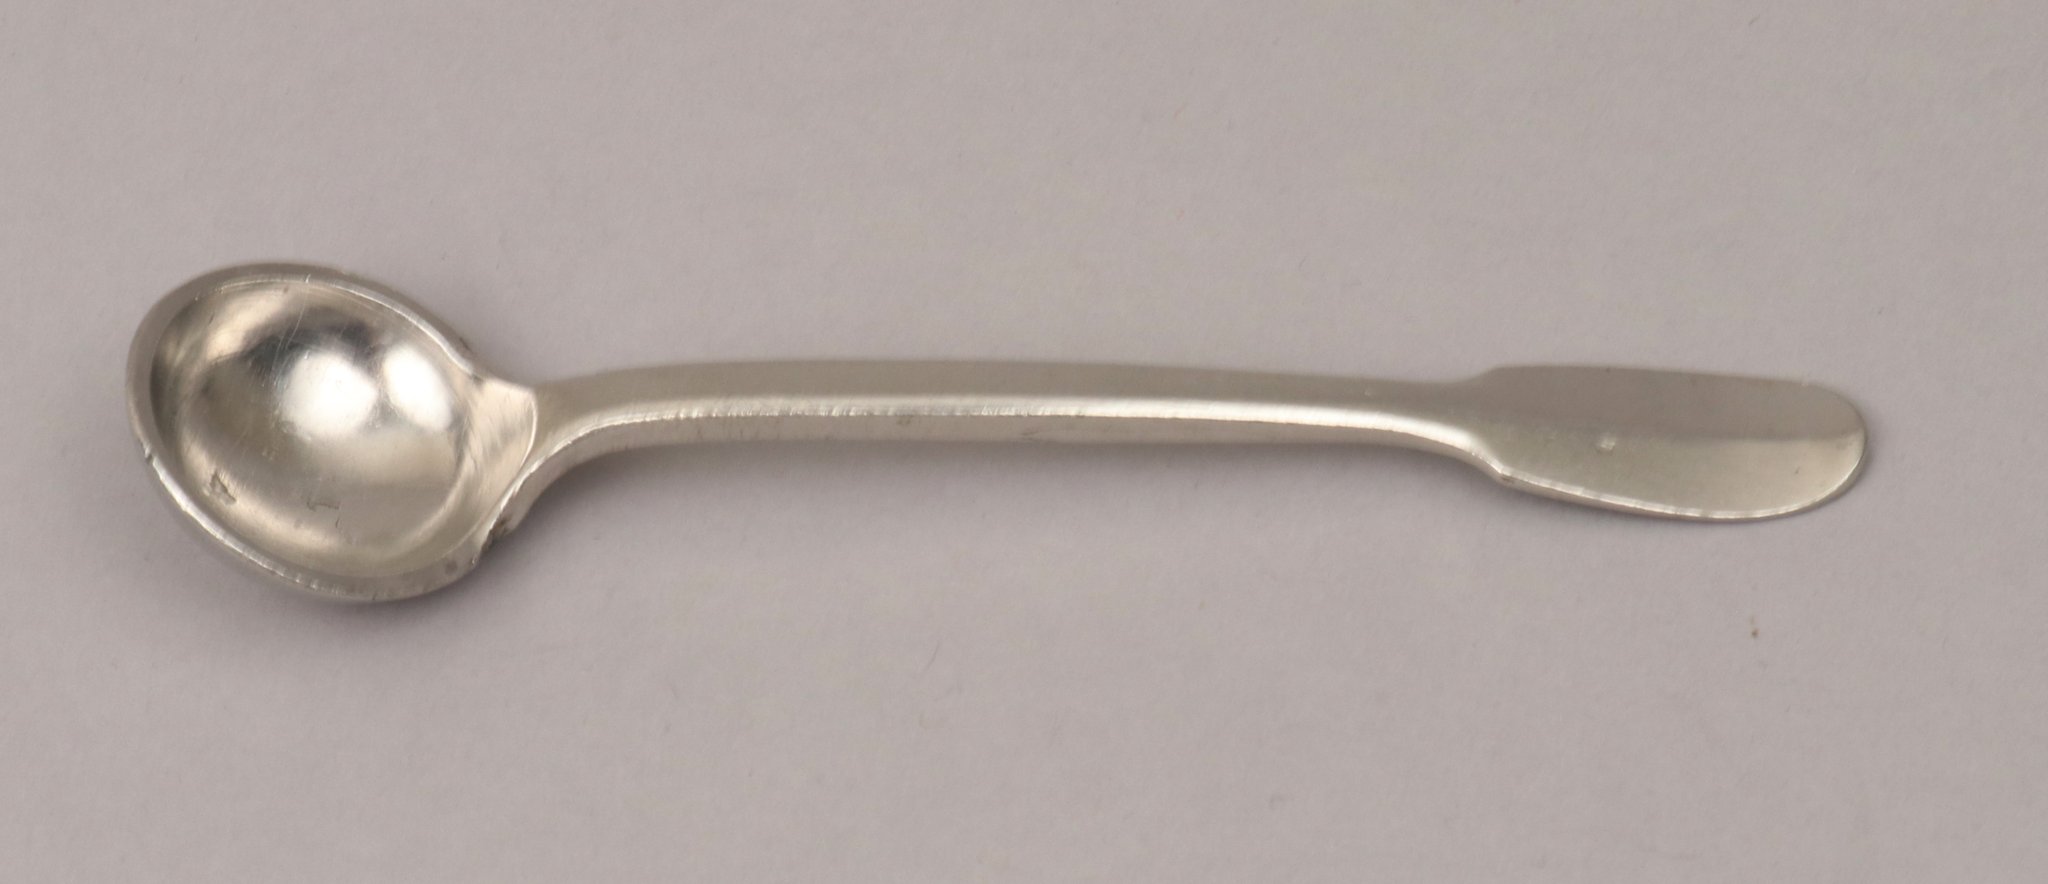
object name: spoon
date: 1801-1833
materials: platinum